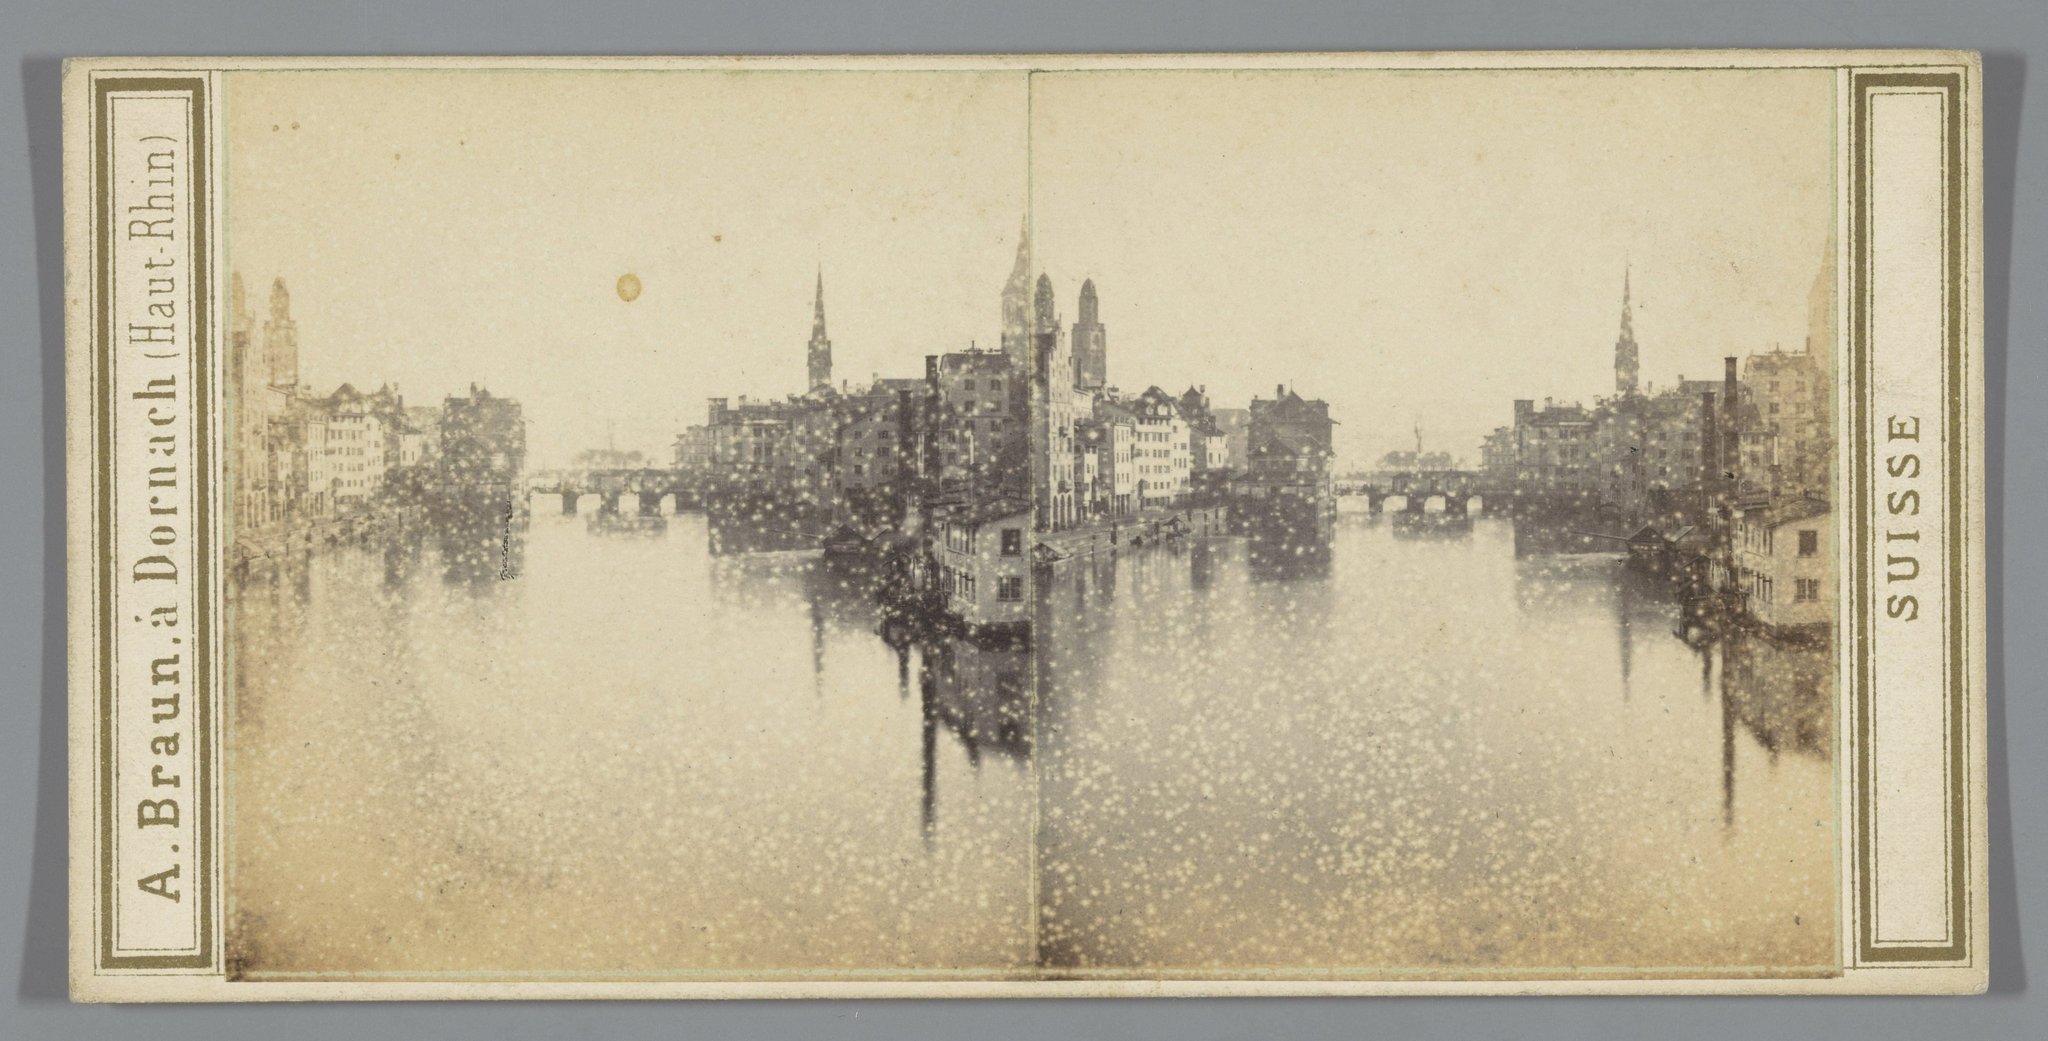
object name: stereograph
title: Vue prise des moulins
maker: Anonymous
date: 1860-1866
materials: cardboard, paper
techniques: albumen print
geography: dornach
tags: river, bridge in city across river, canal, etc.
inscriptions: number: ‘No 3655.’